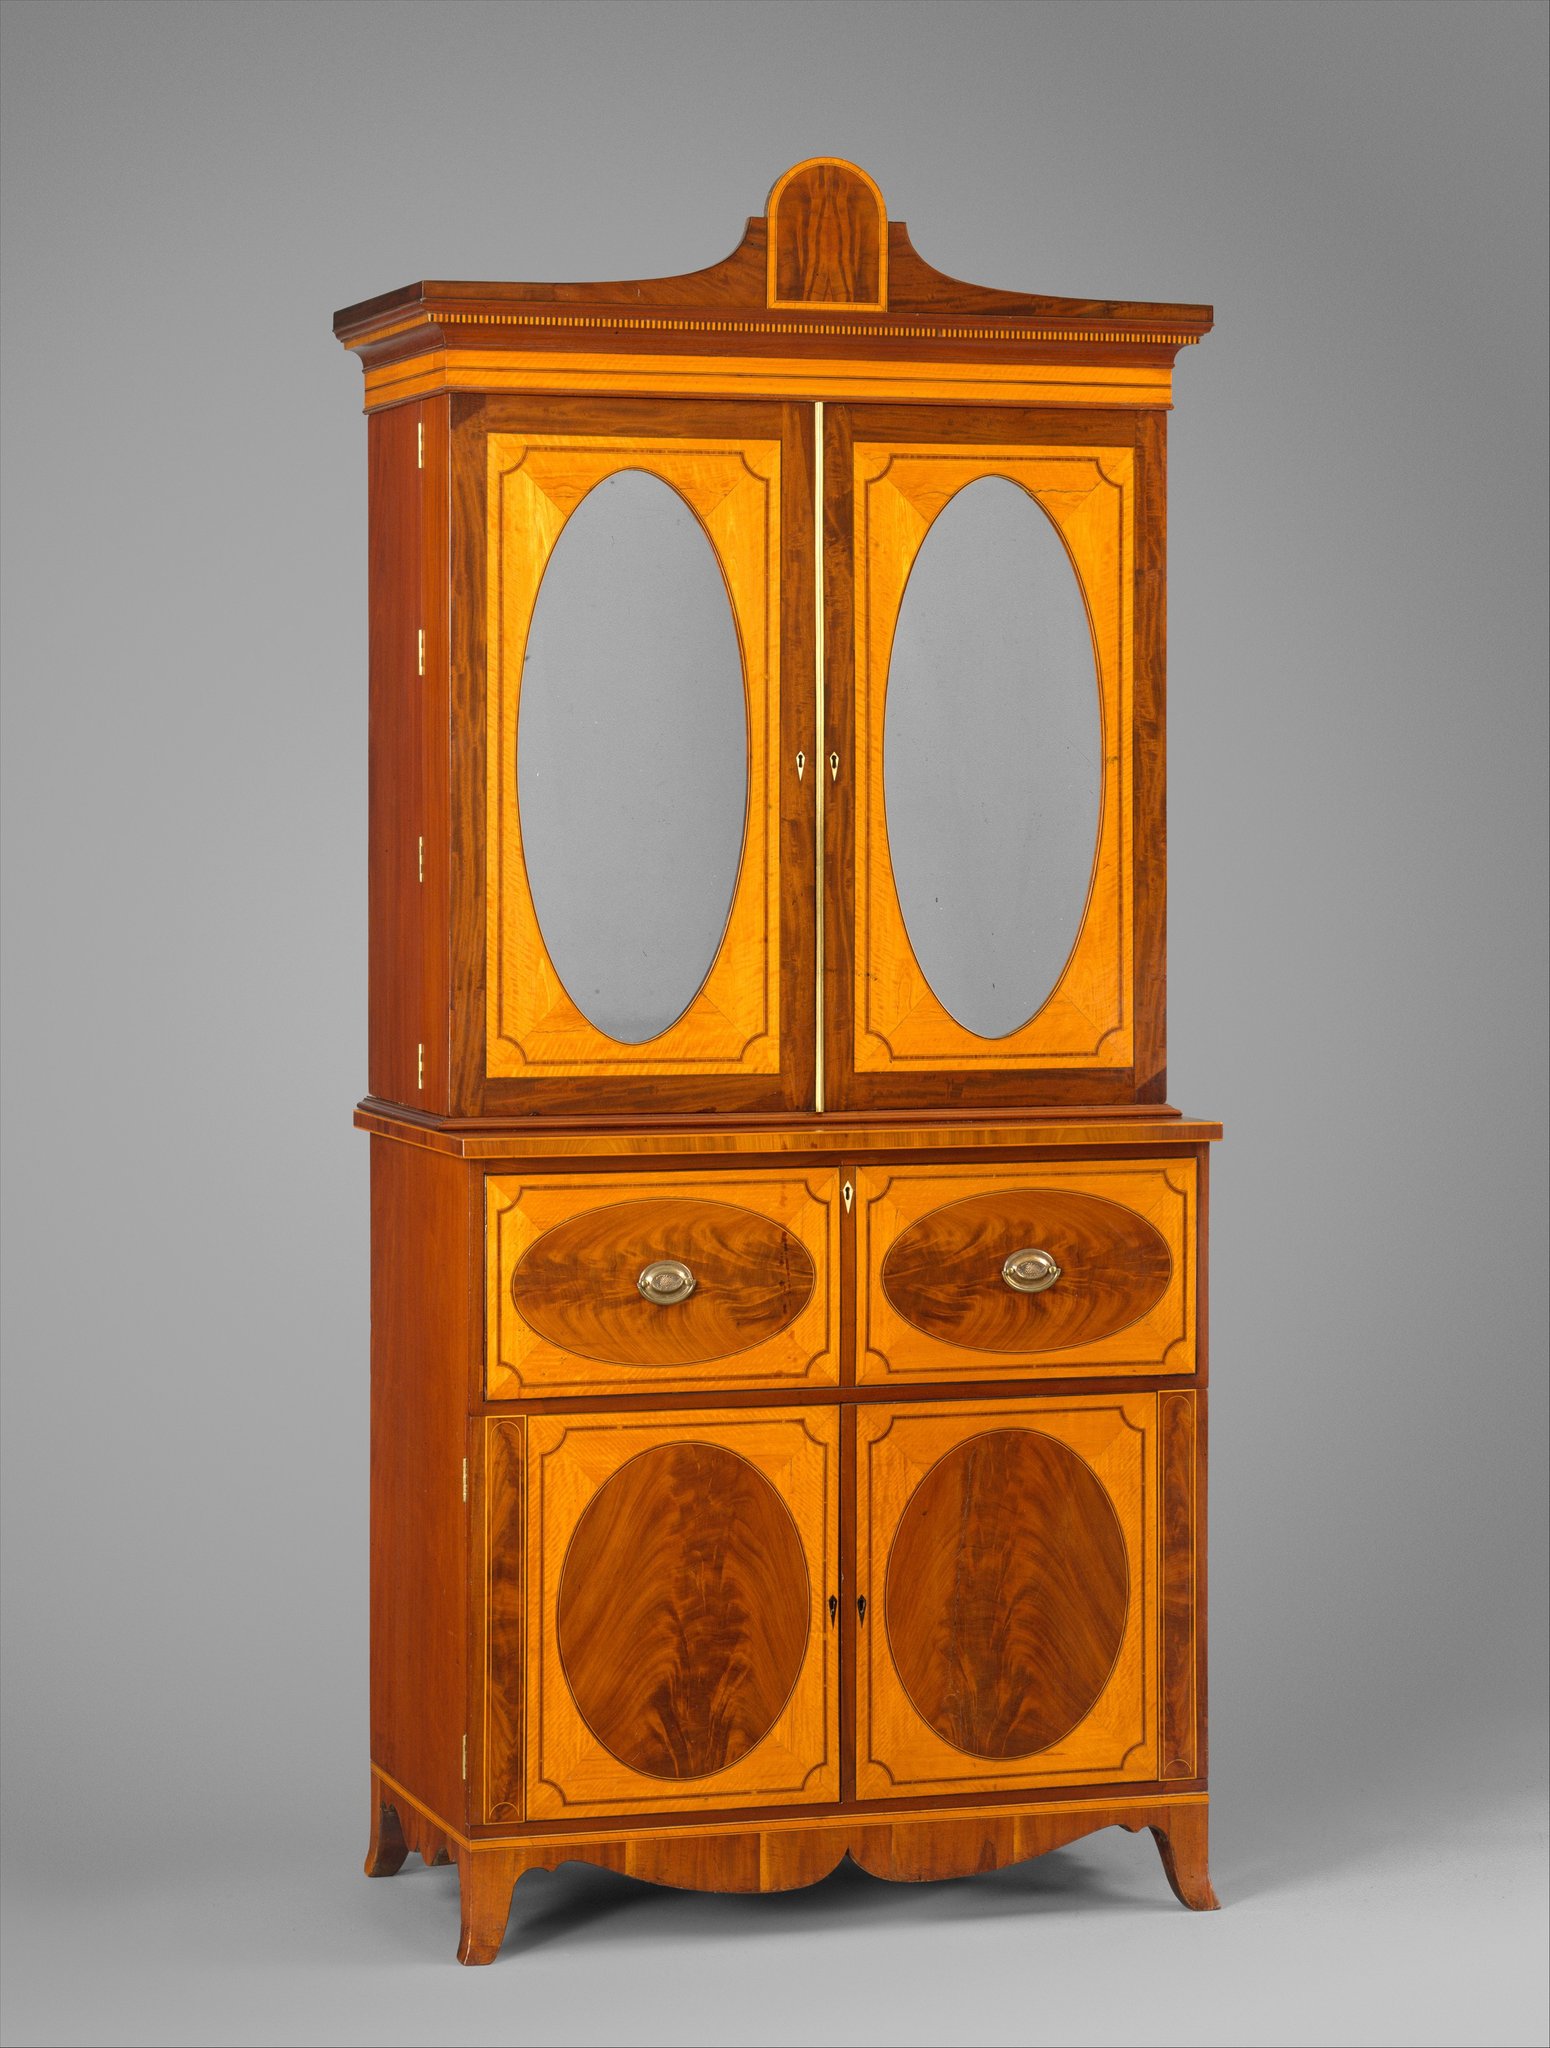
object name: desk and bookcase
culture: american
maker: john davey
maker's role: maker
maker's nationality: american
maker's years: 1794-1822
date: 1805-1810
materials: wood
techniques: veneering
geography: united states